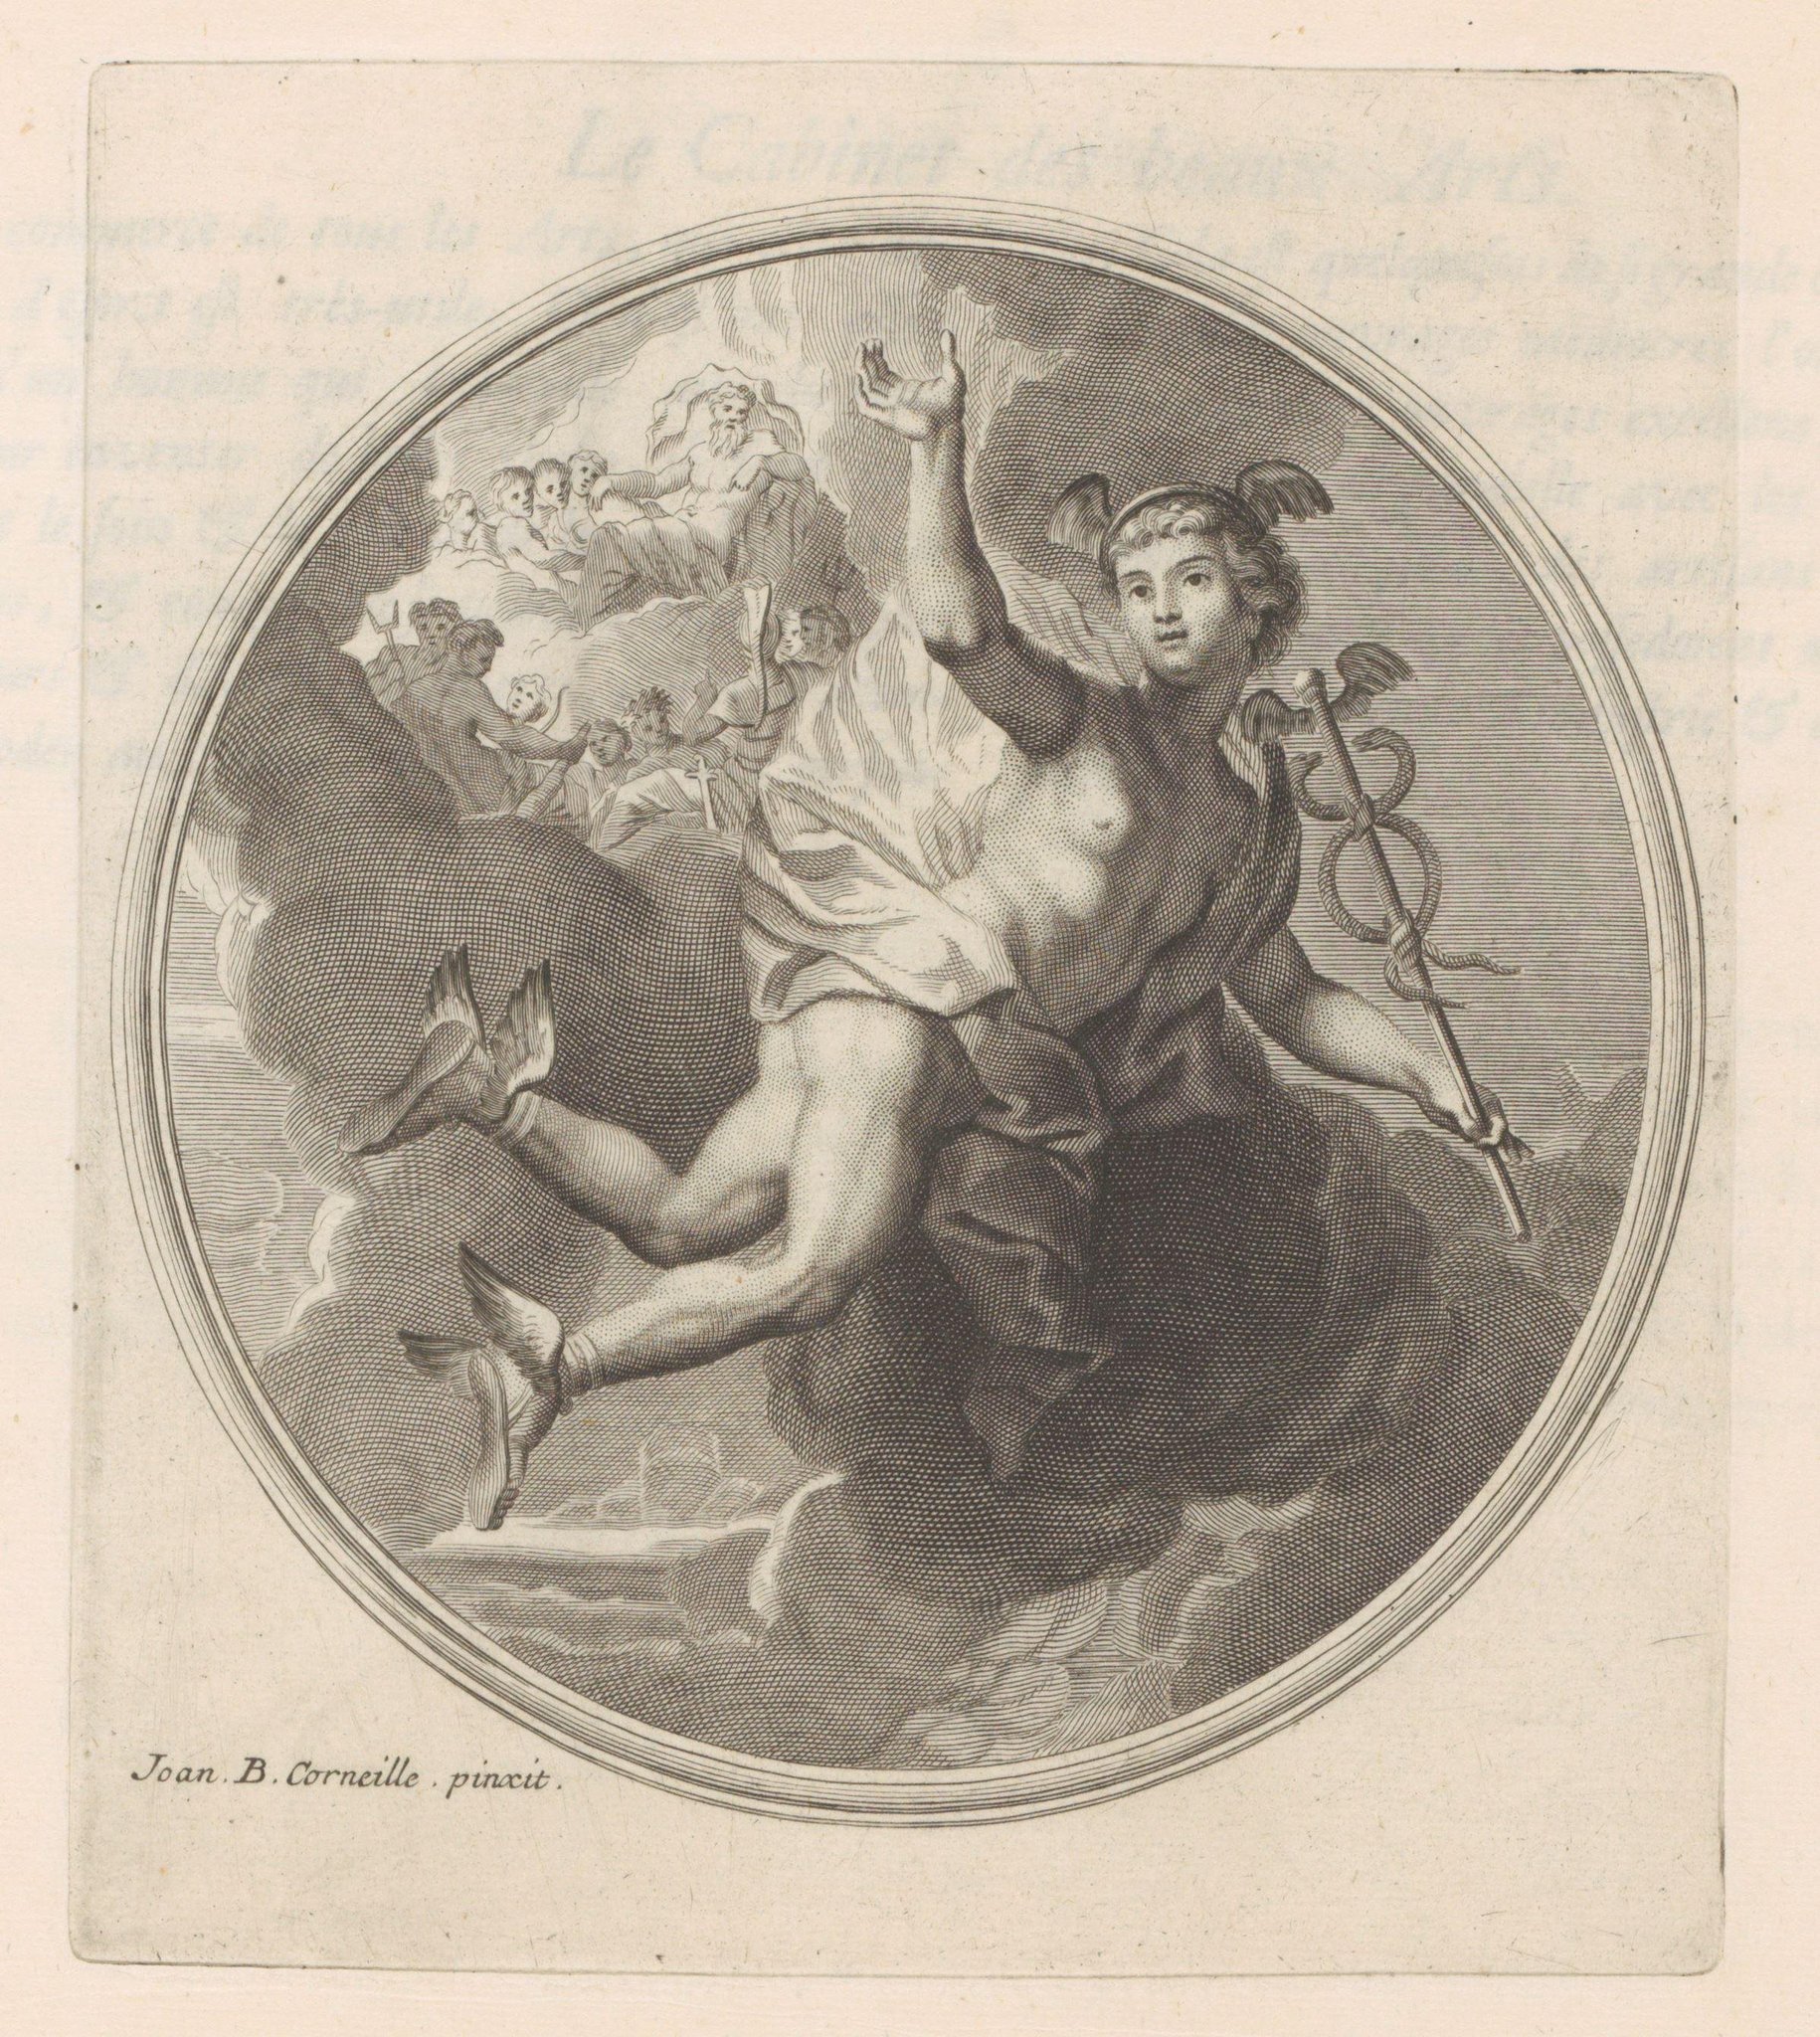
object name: album leaf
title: Mercurius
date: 1695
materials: paper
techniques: engraving, etching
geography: paris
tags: (story of) mercury (hermes), (decorated) ceiling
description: Plafondstuk met de god Mercurius, vliegend met de caduceus in zijn hand. Op de achtergrond de goden van de Olympus op de wolken. Prent maakt deel uit van een album.